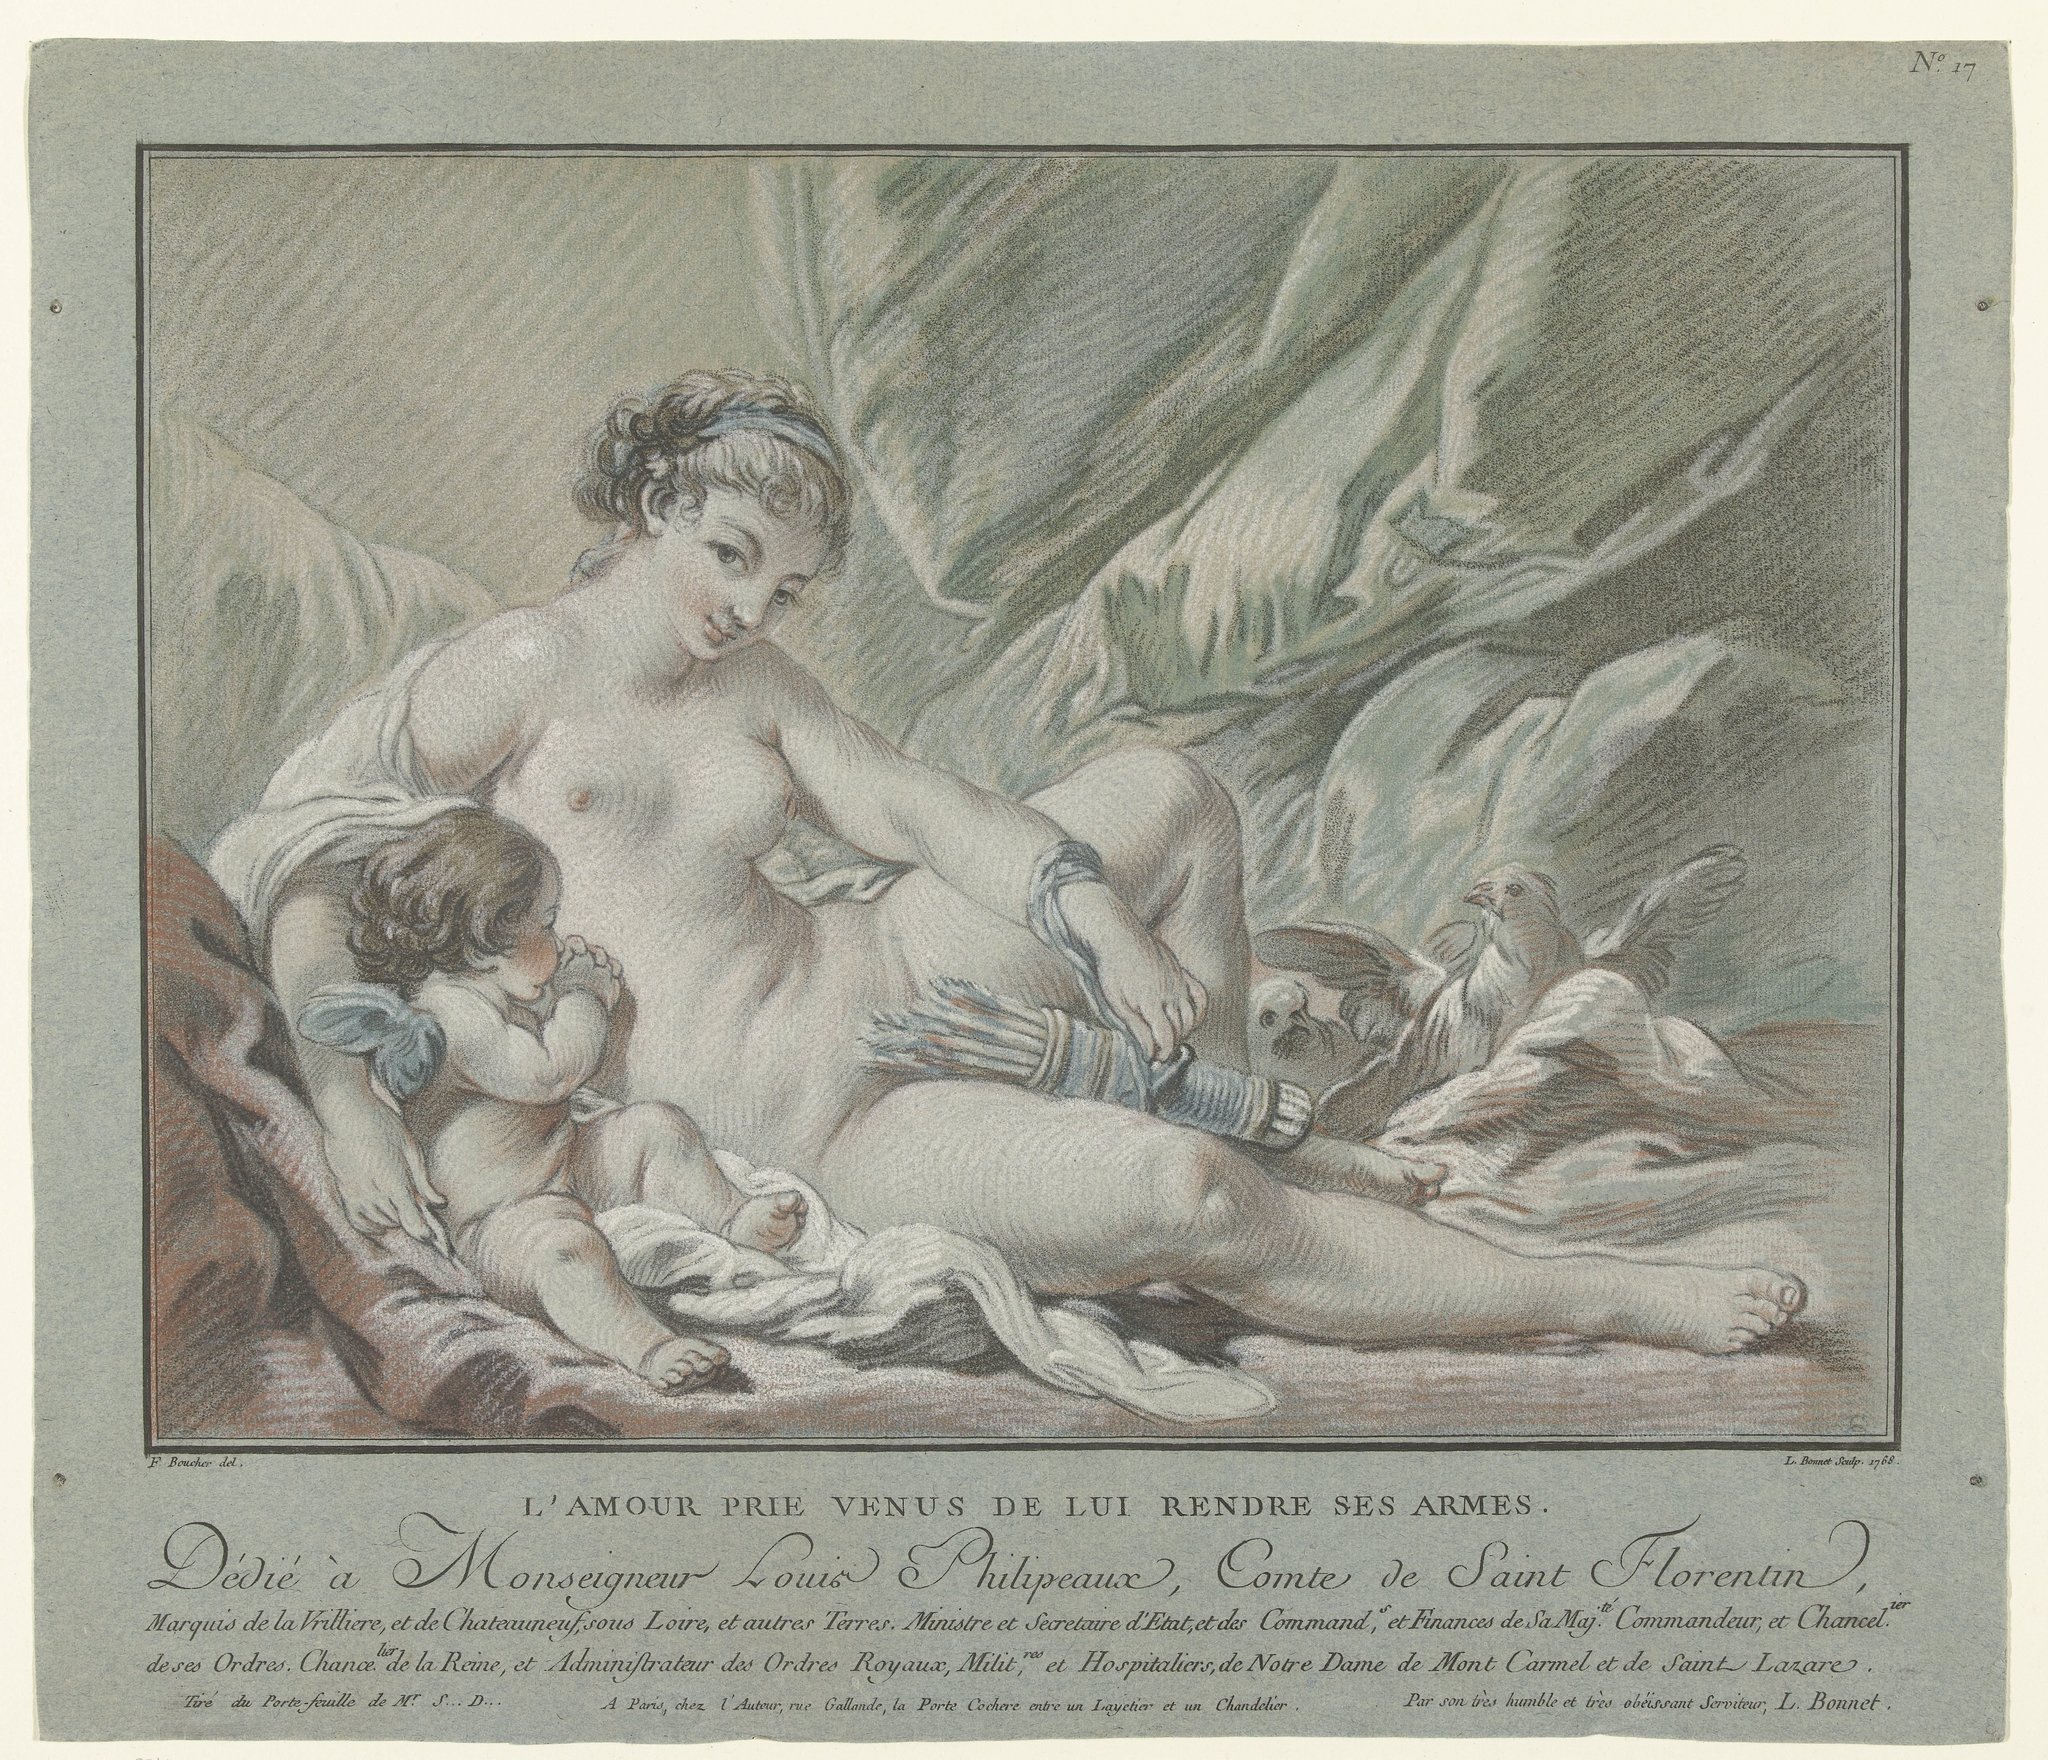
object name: print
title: L'Amour prie Venus de lui rendre ses armes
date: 1768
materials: paper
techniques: printmaking, etching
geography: paris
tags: venus and cupid (cupid not being mere attribute)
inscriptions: date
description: Liggende naakte Venus, met de pijlenkoker van Cupido in haar linkerhand. Naast haar Cupido met zijn handen gevouwen. Onder de voorstelling een tekst in het Frans.